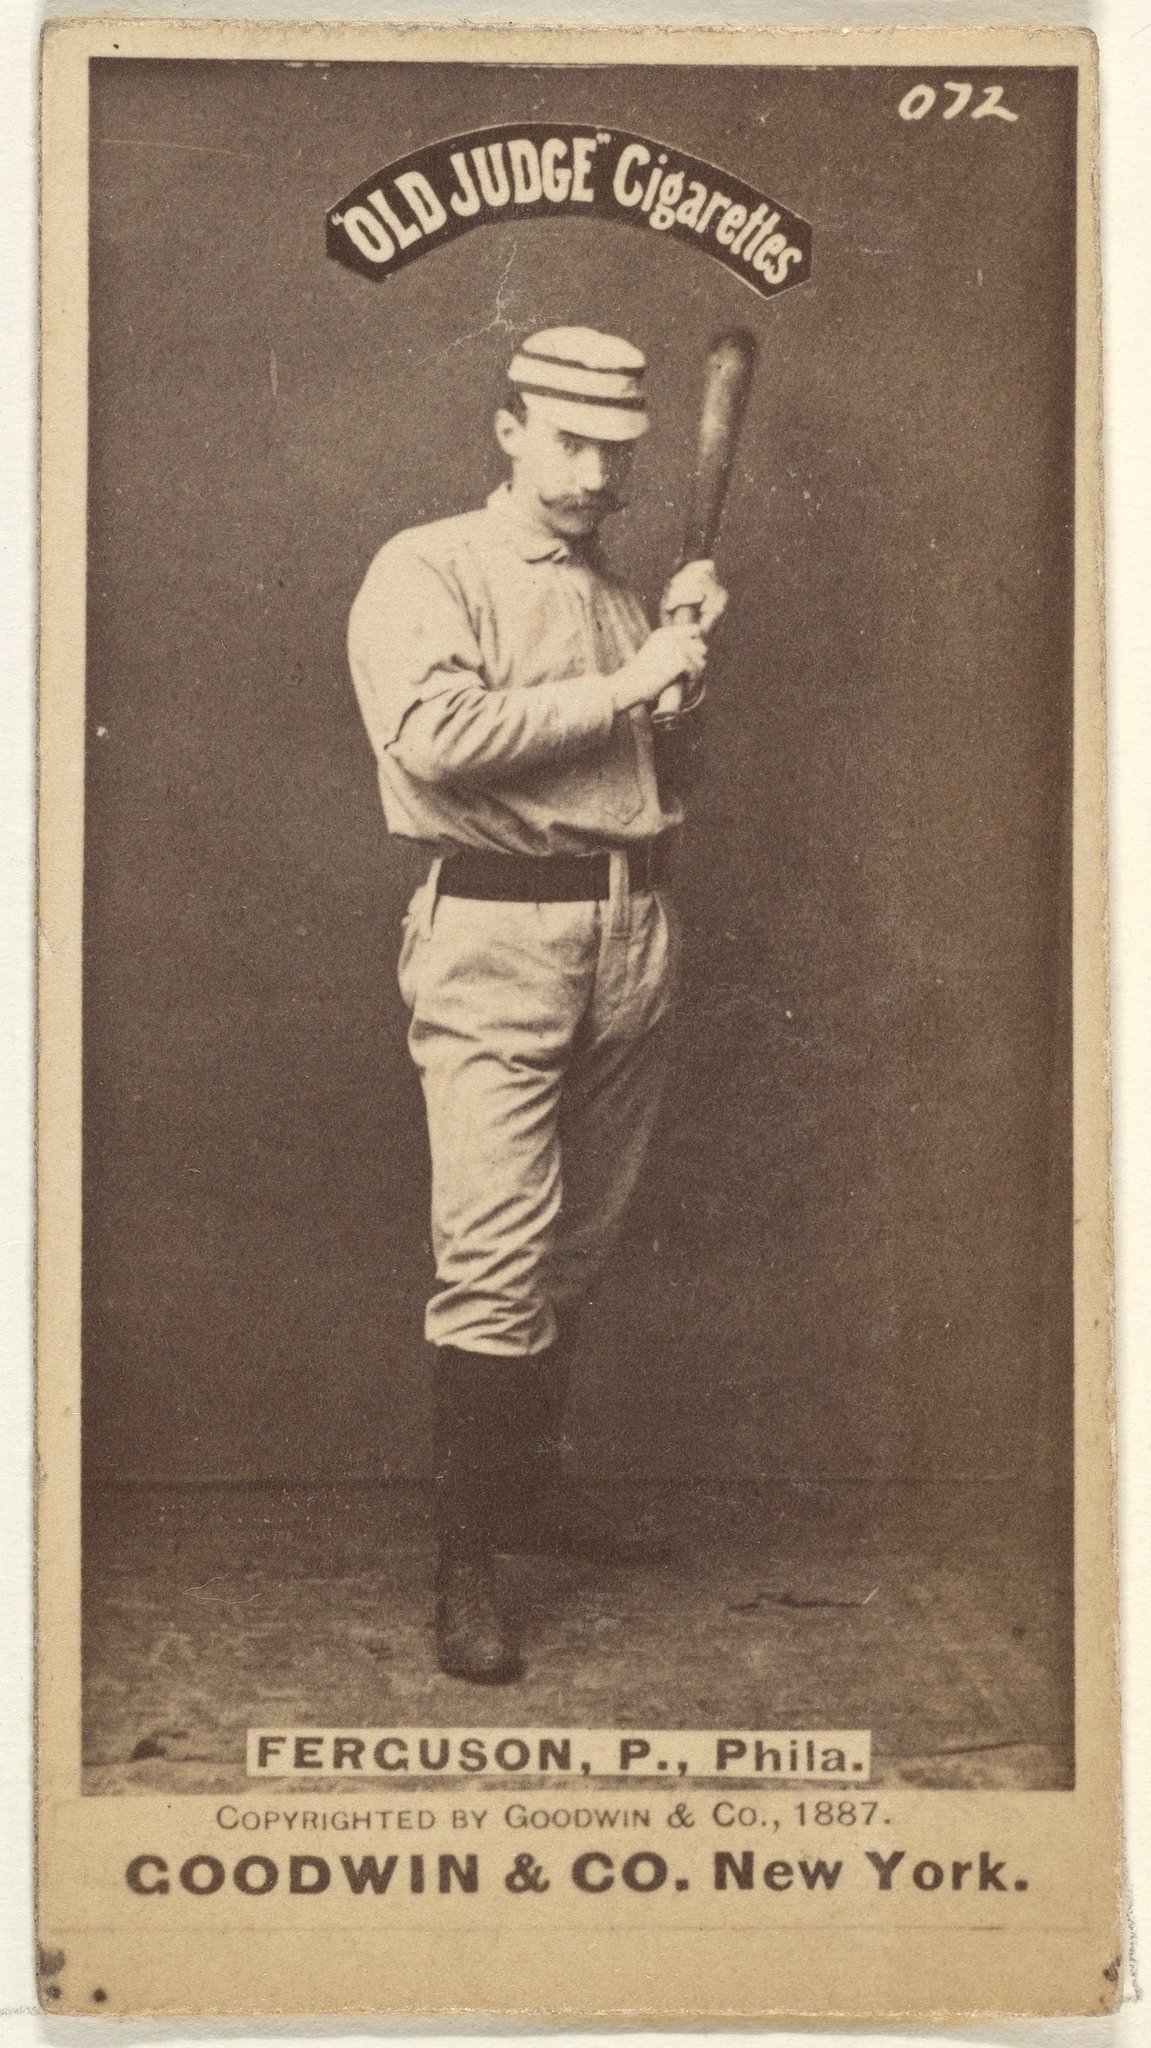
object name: baseball card, photograph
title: Charles J. "Charlie" Ferguson, Pitcher, Philadelphia, from the Old Judge series (N172) for Old Judge Cigarettes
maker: goodwin & company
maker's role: publisher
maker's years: 1850-1950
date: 1887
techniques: albumen silver print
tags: men,portraits,baseball,athletes